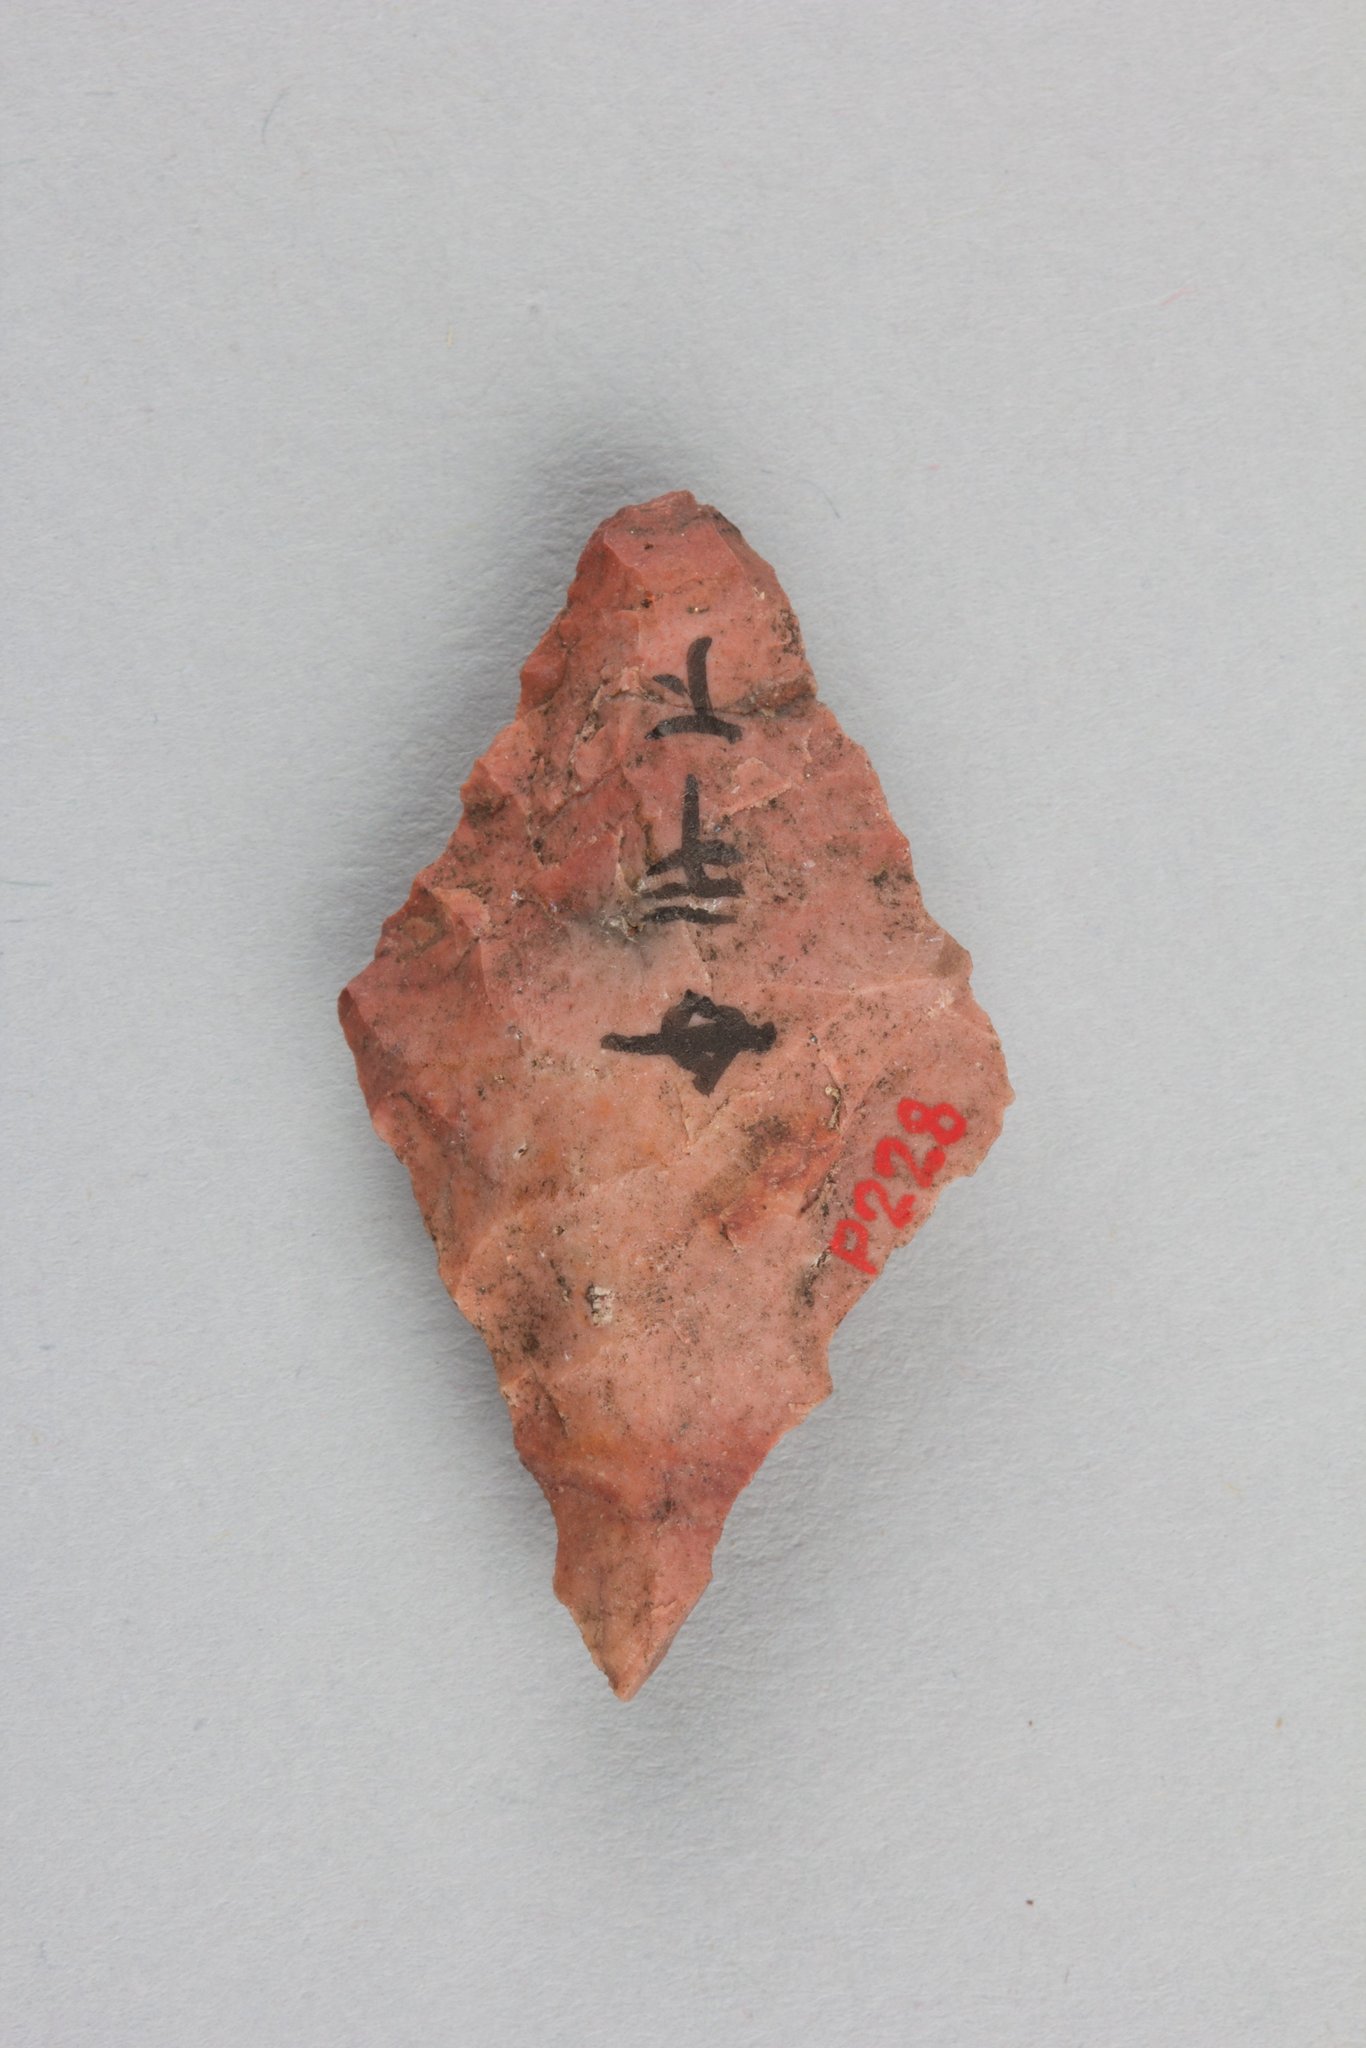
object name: arrowhead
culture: japanese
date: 1500-1000 BCE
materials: stone